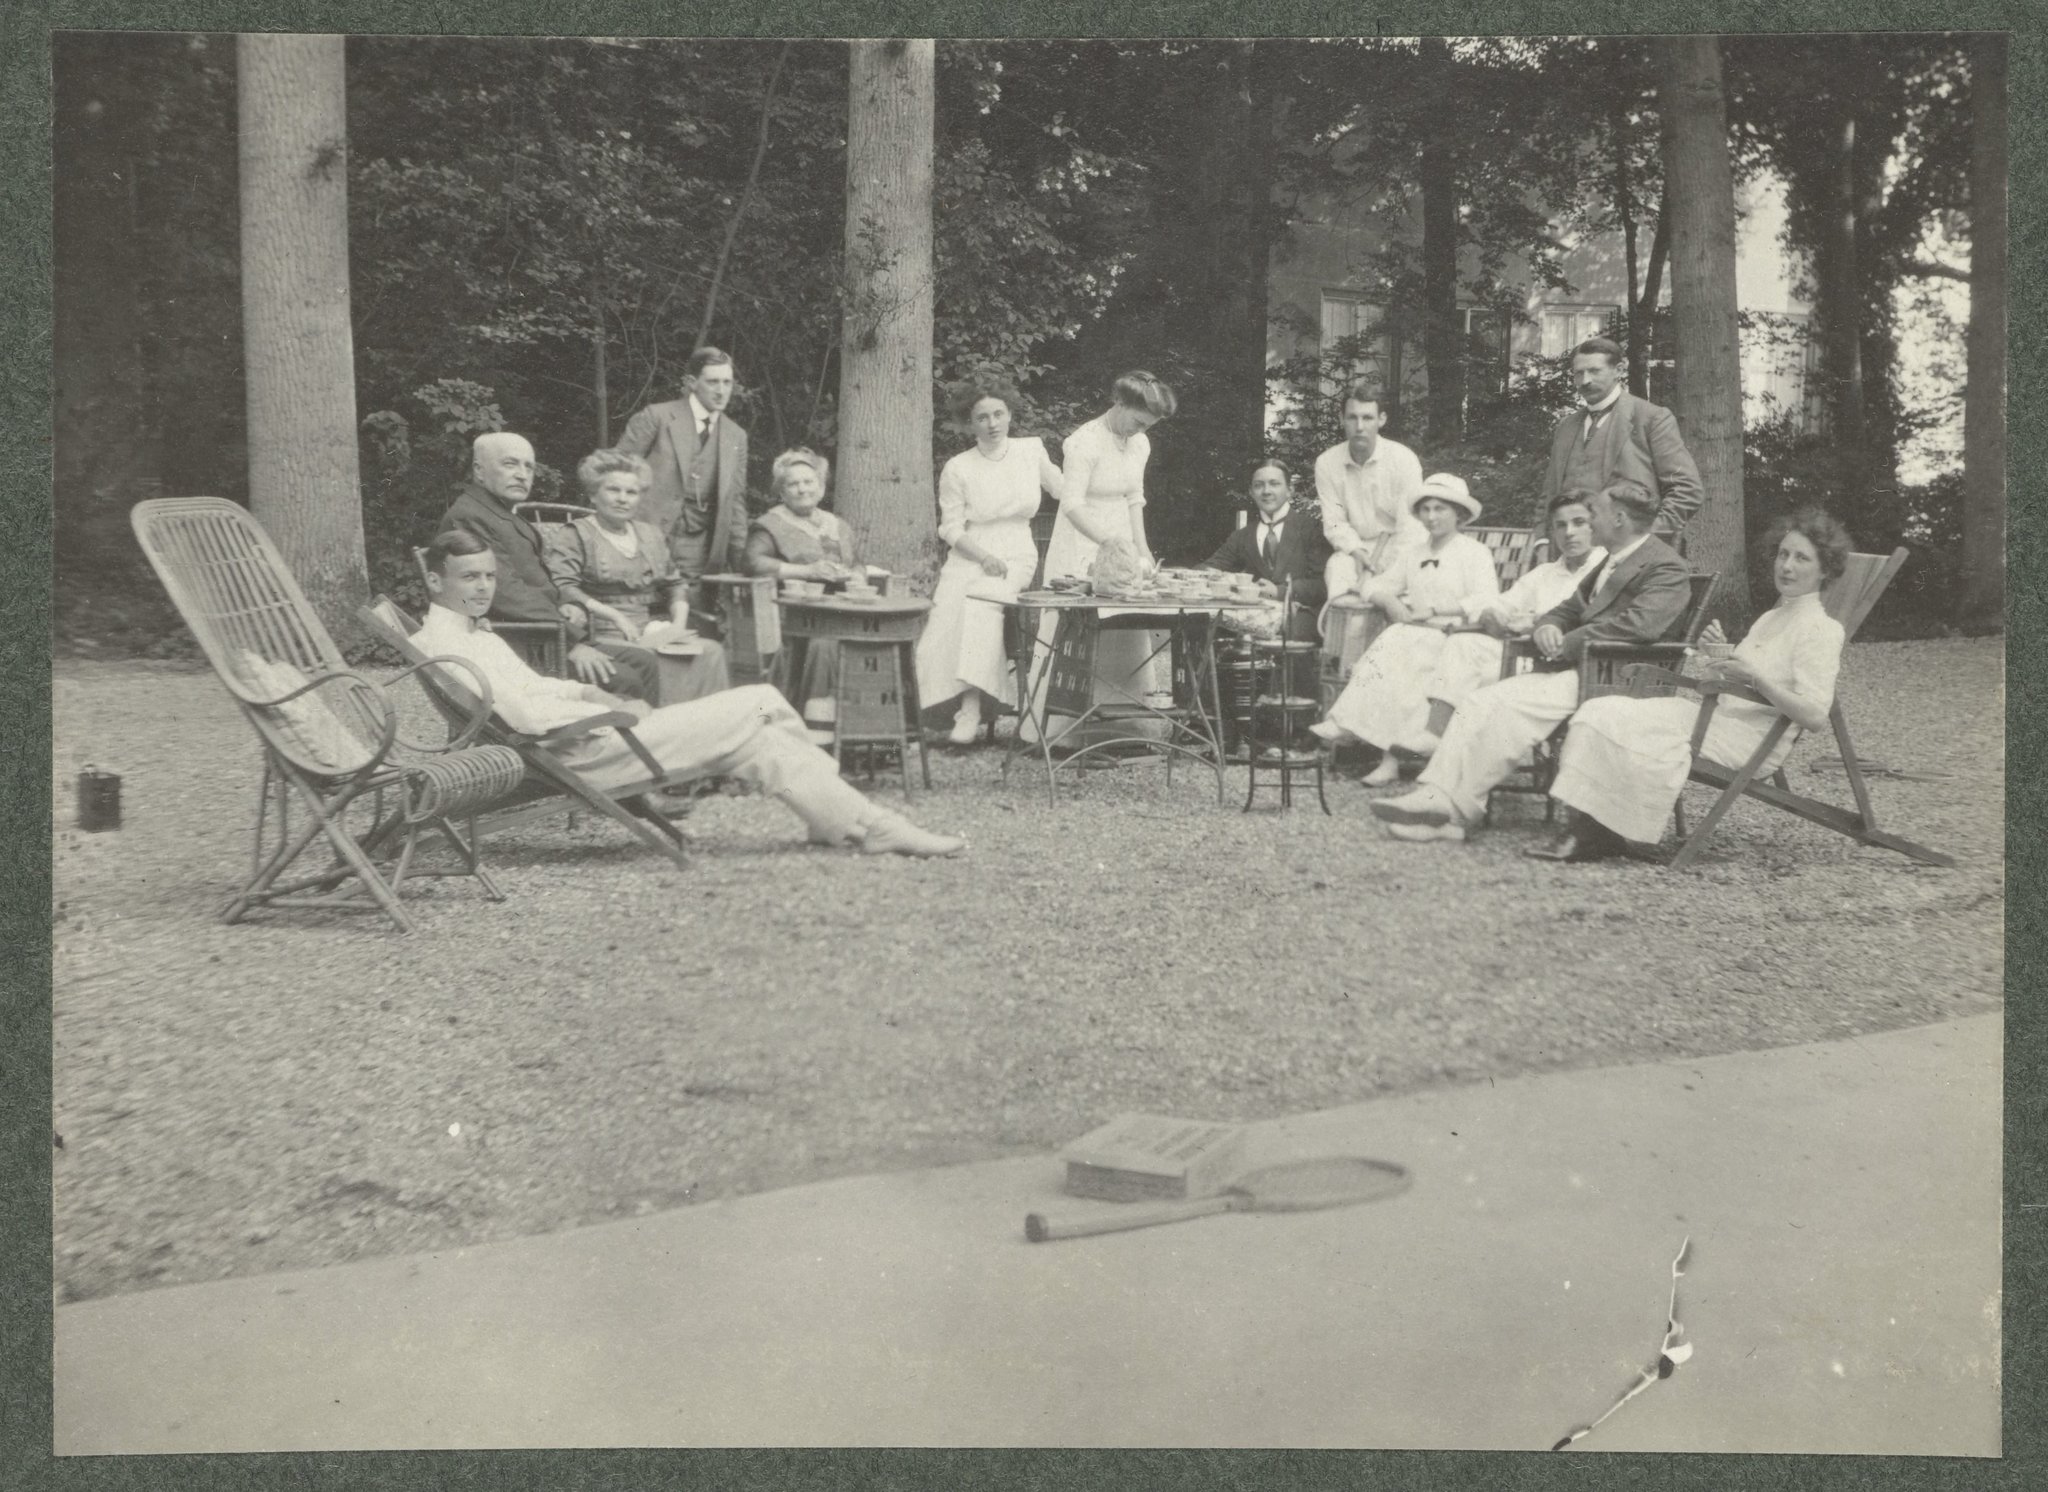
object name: photograph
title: Groepsportret van de familie Kessler aan een buitentafel tijdens een kopje koffie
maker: geldolph adriaan kessler (dolph)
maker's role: fotograaf, industrieel, voetballer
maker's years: 1884-1945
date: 1913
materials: paper, photographic support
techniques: photography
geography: netherlands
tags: official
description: Onderdeel van overdracht foto's en albums van familie Kessler-de Lange